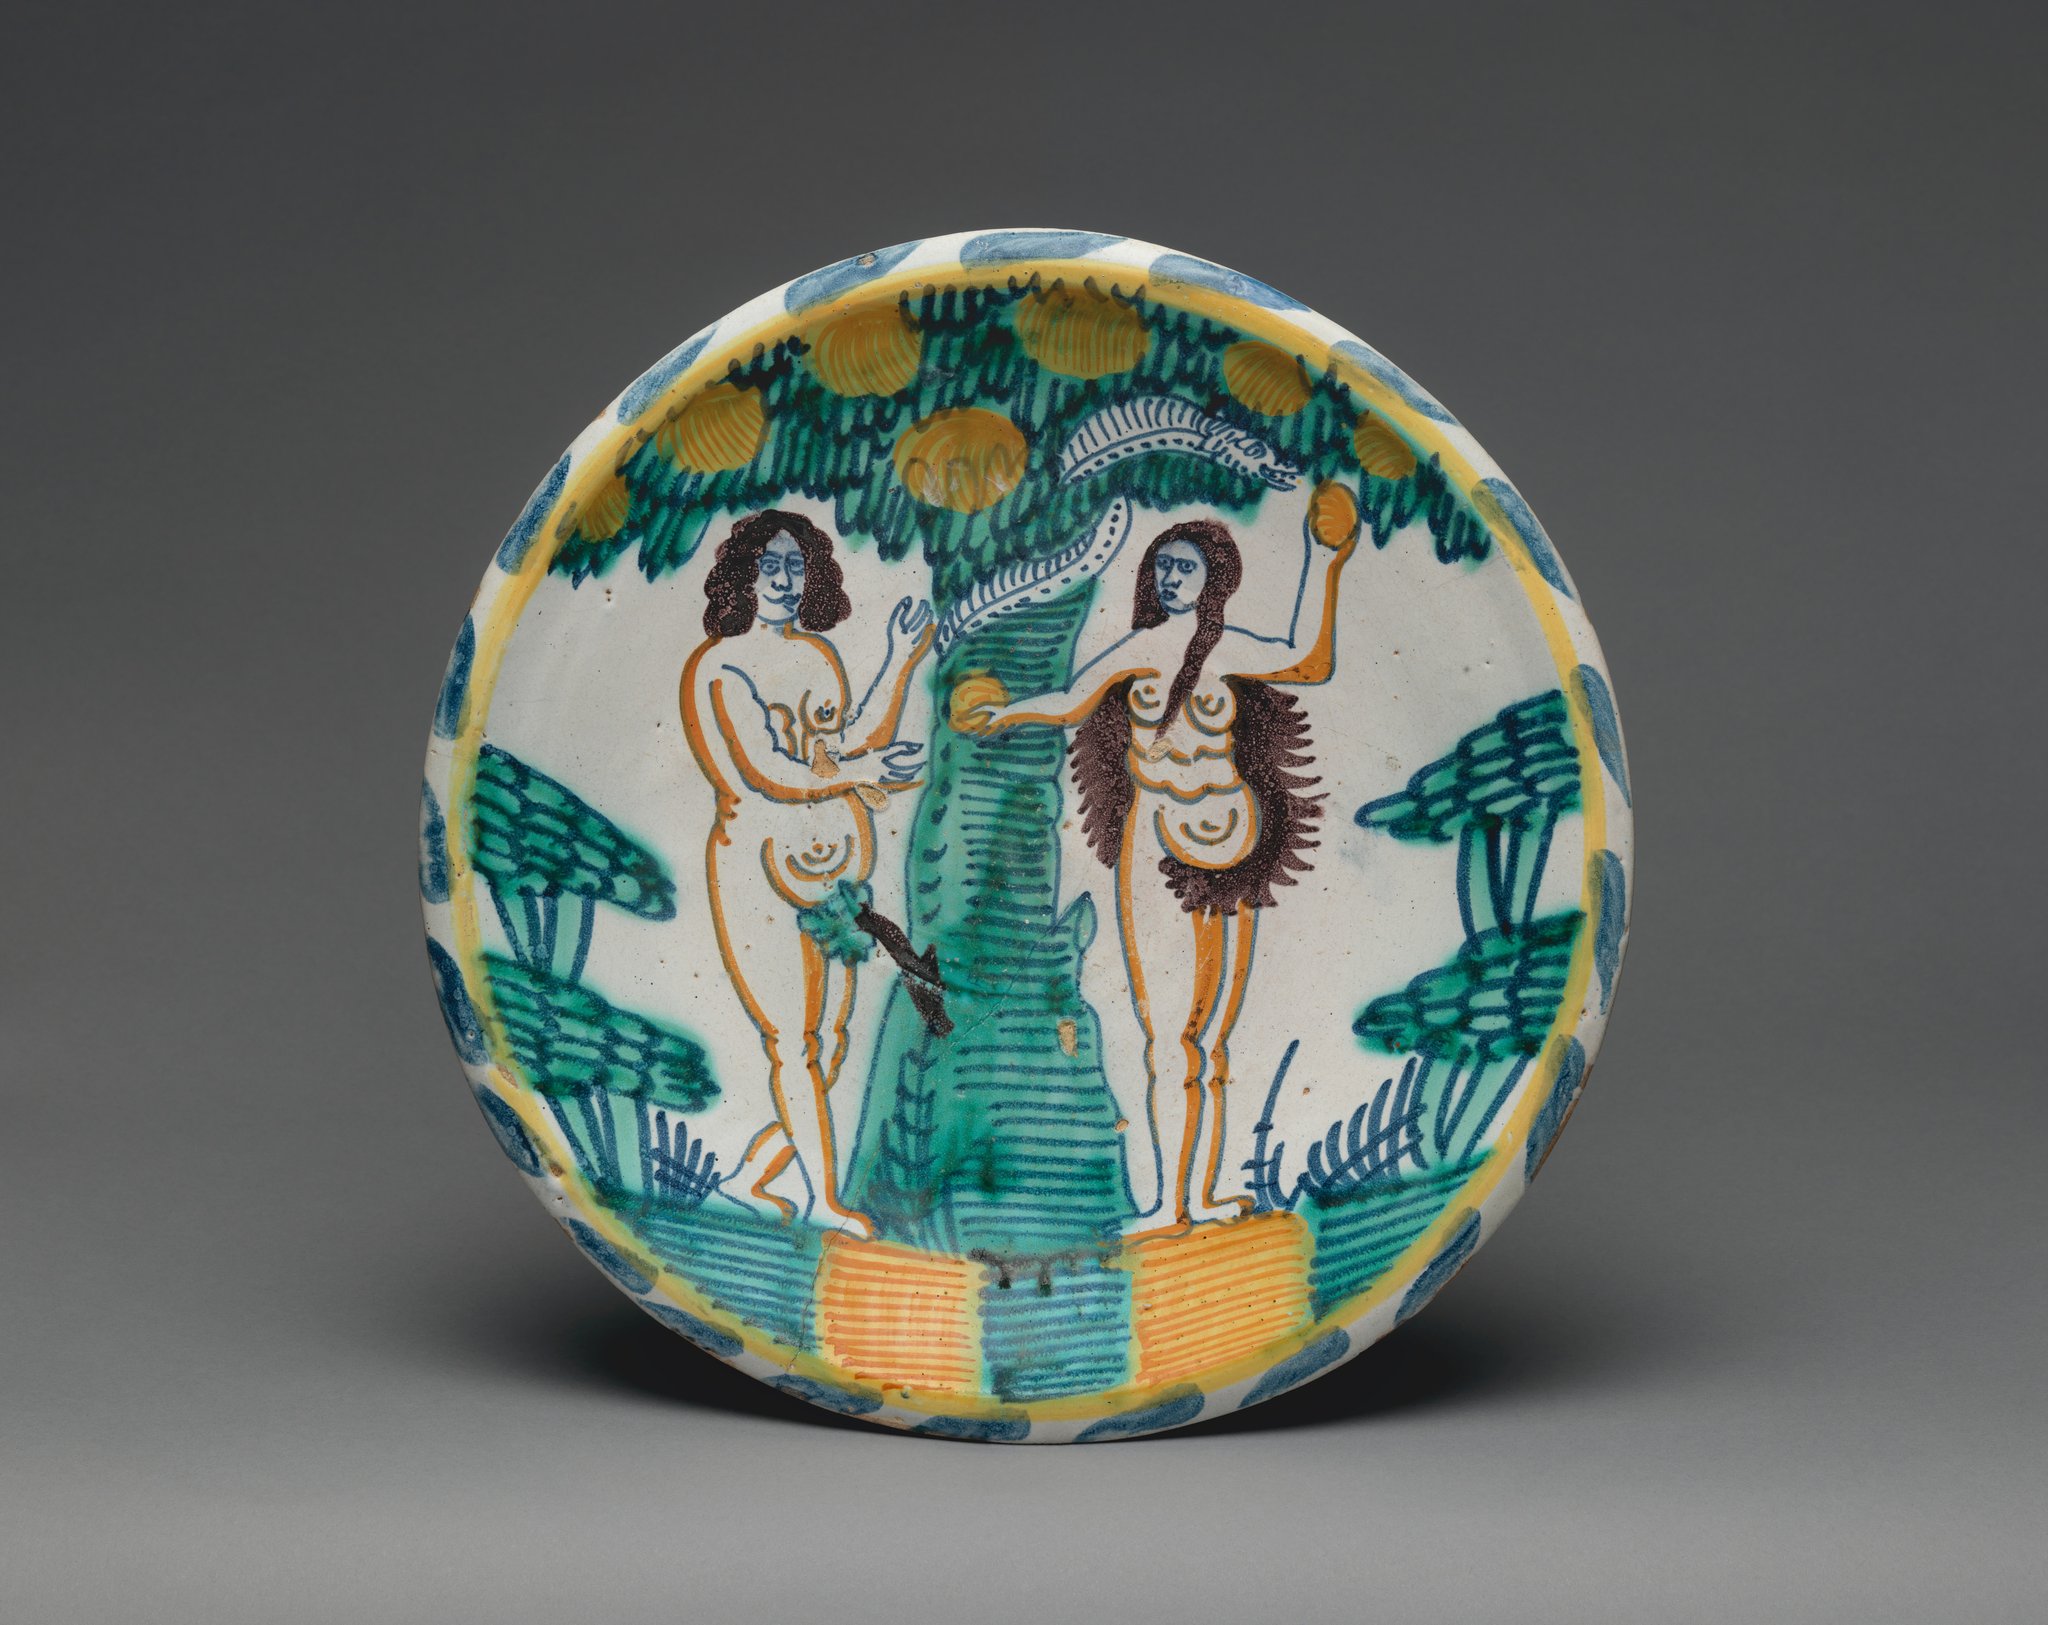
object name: dish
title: Dish with Temptation of Adam and Eve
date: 1680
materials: earthenware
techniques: glazing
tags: adam,eve